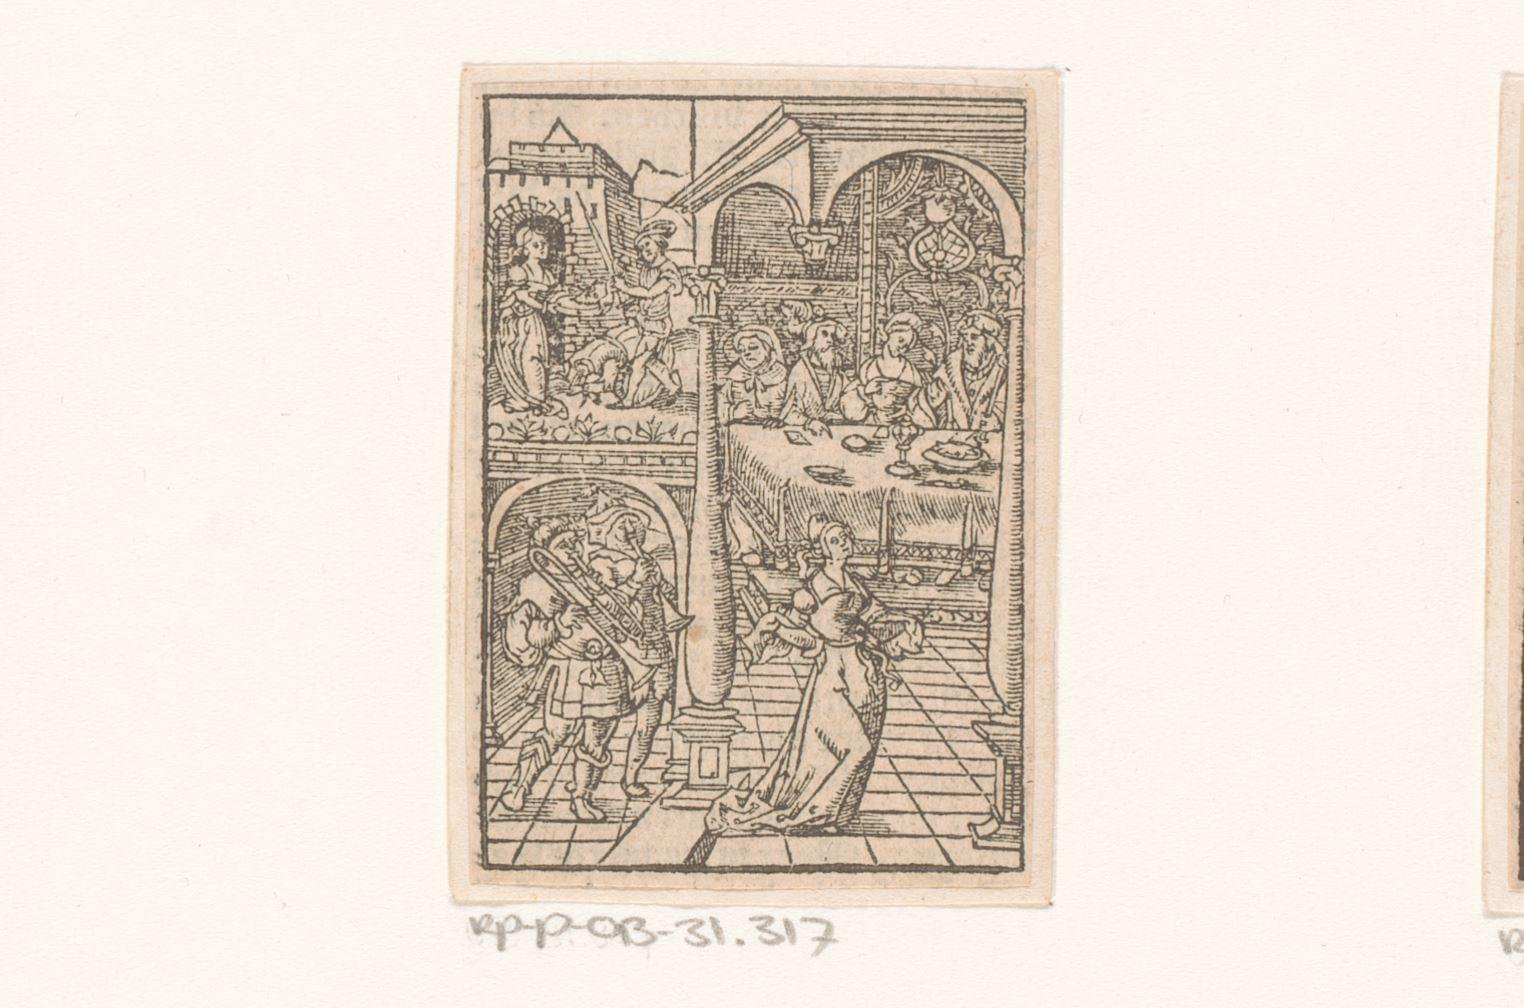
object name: print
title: Salome danst op het feest van Herodes en de onthoofding van Johannnes de Doper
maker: Anonymous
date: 1600-1699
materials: paper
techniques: letterpress printing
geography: netherlands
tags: salome is given the head of john the baptist by the executioner, salome dancing during the banquet of herod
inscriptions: collector's mark: Lugt 240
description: Herodes zit met zijn gasten aan een tafel en kijkt naar de dansende Salome. Hij belooft haar alles te geven wat ze hem vraagt. Zij vraagt vervolgens het hoofd van Johannes de Doper. Op de achtergrond heeft de beul net het hoofd van Johannes de Doper afgehouwen en legt het op de schaal die wordt vastgehouden door Salome.